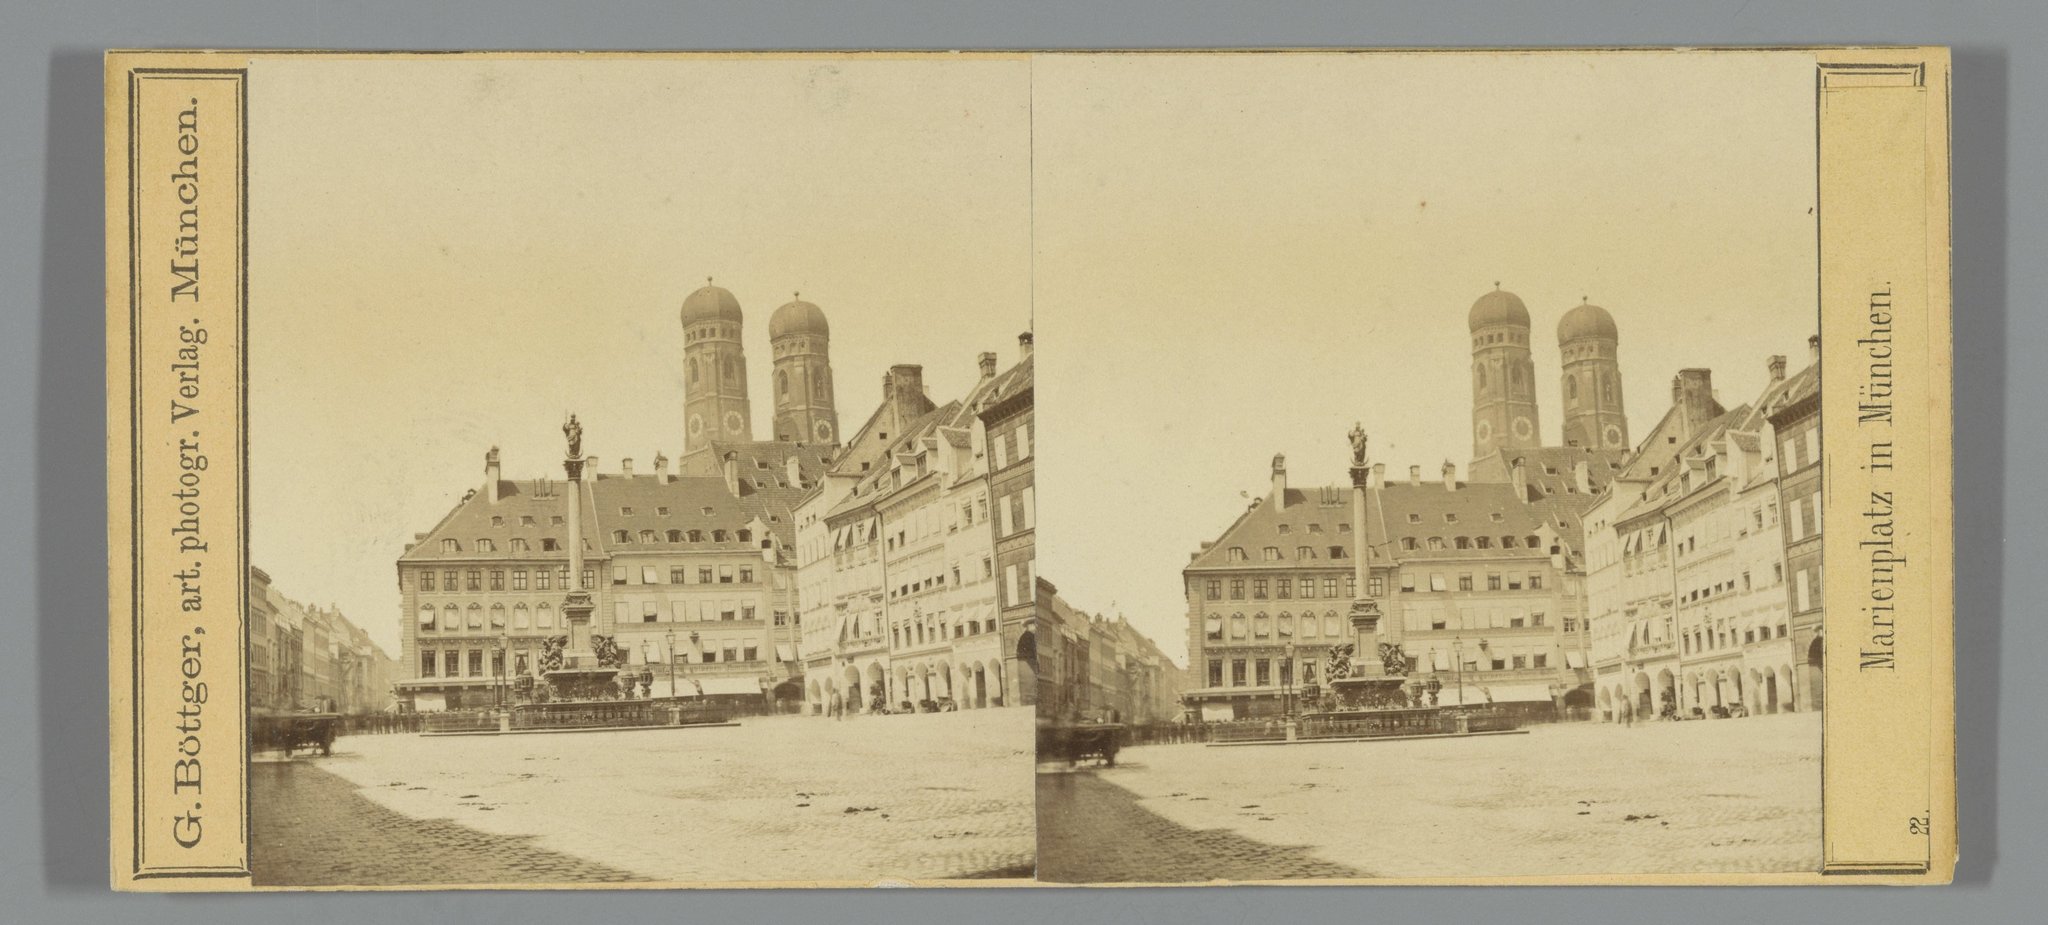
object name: stereograph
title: Gezicht op de Marienplatz te München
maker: georg böttger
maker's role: fotograaf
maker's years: 1821-1902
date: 1870-1885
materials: cardboard, photographic support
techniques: albumen print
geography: munich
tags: square, place, circus, etc., church (exterior)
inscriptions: number: ‘22.’, inscription: ‘G. 3.’